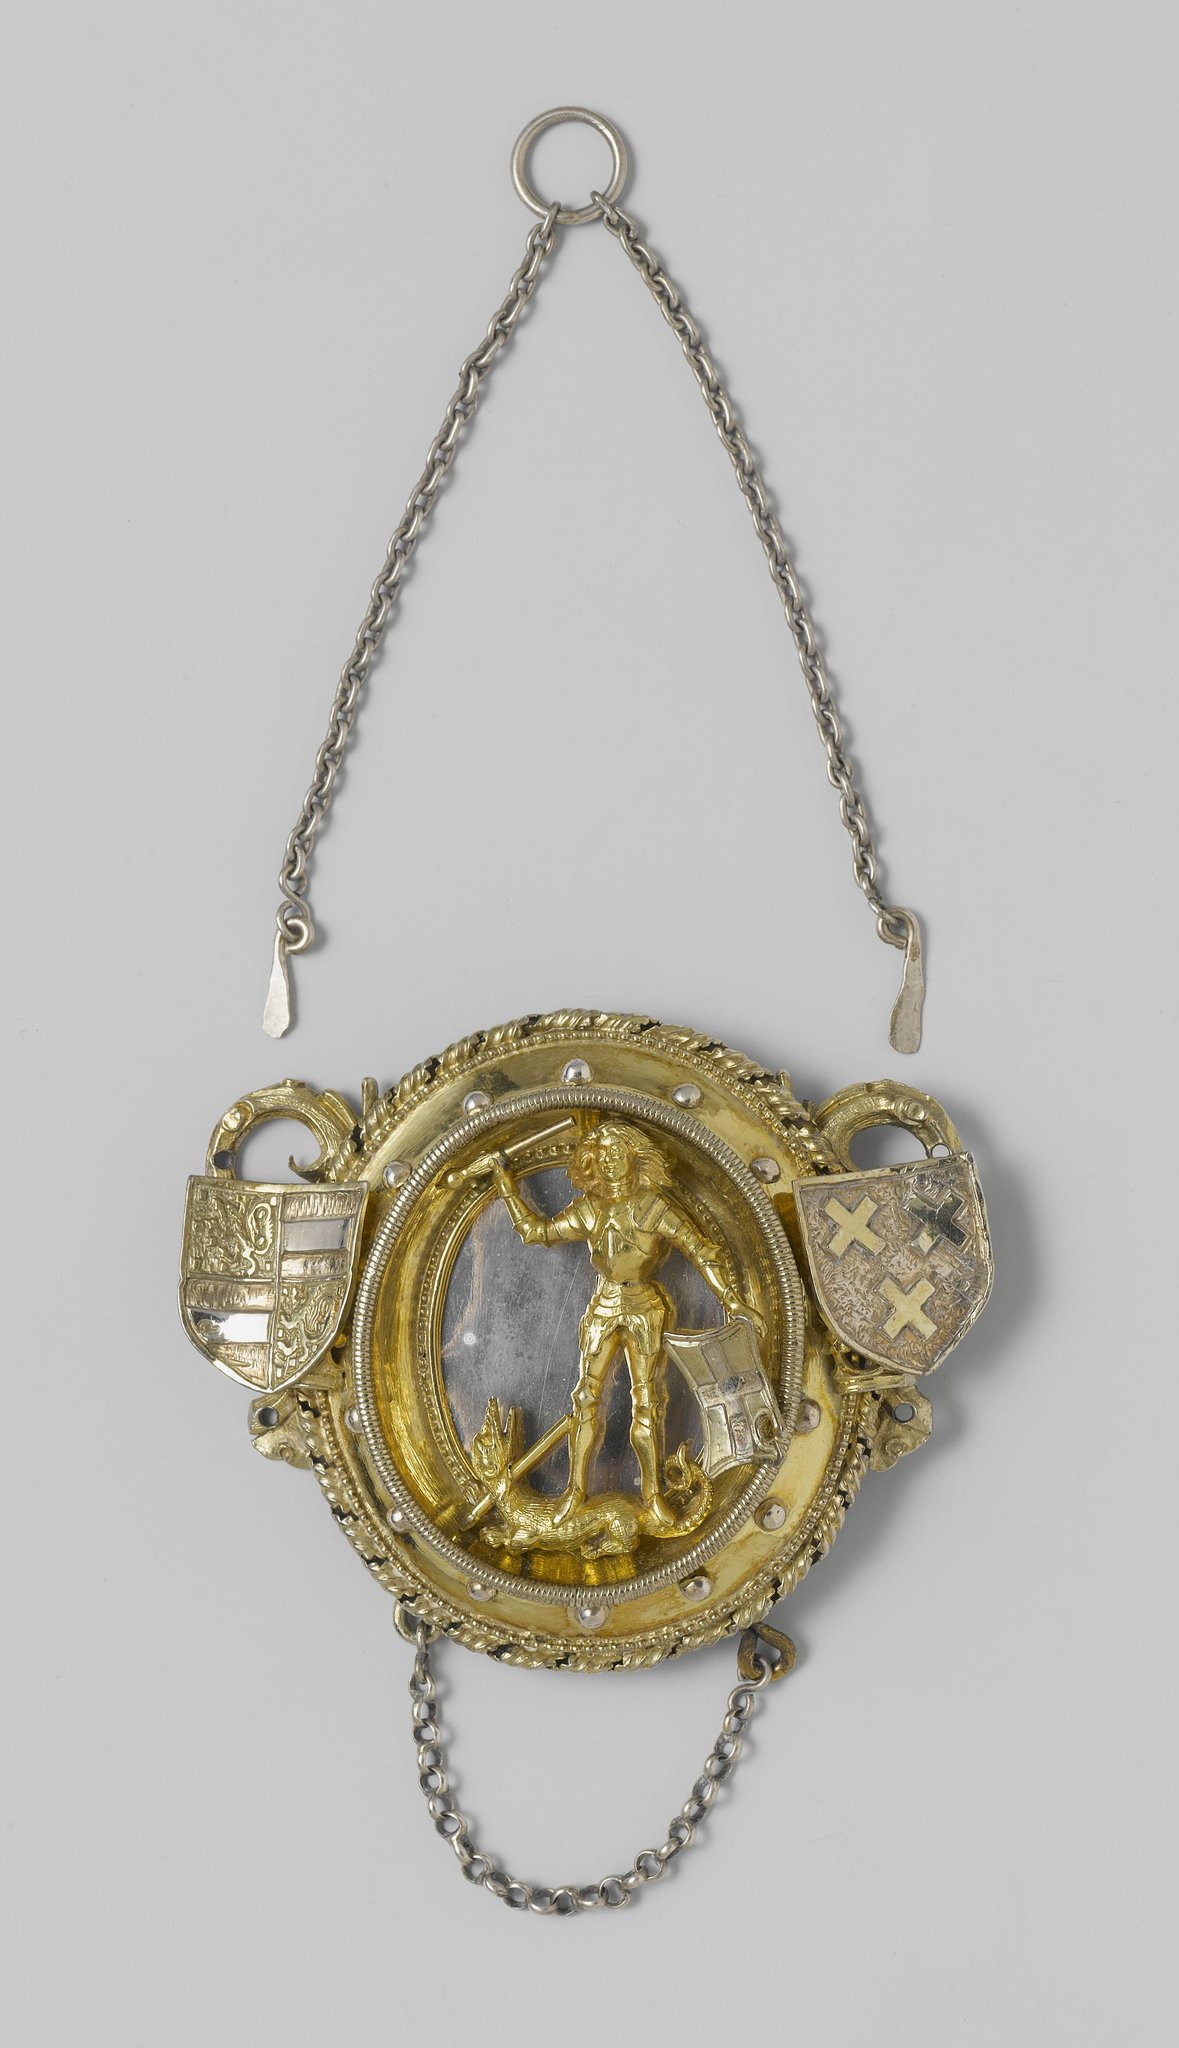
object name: insignia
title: Badge of the Guild of Saint George in Breda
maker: Anonymous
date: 1500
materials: silver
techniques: casting, gilding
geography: brabant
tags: st. george and the dragon: dressed in armour and mounted on a (white) horse he brandishes his sword (his lance lies already broken on the ground); the princess nearby may be shown praying or fleeing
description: At the centre of this civic guard badge is Saint George, who has killed a dragon with his lance. He was the patron saint of crossbowmen. He is flanked by two coats of arms: at left those of the Lords of Breda and on the right the arms of the town.